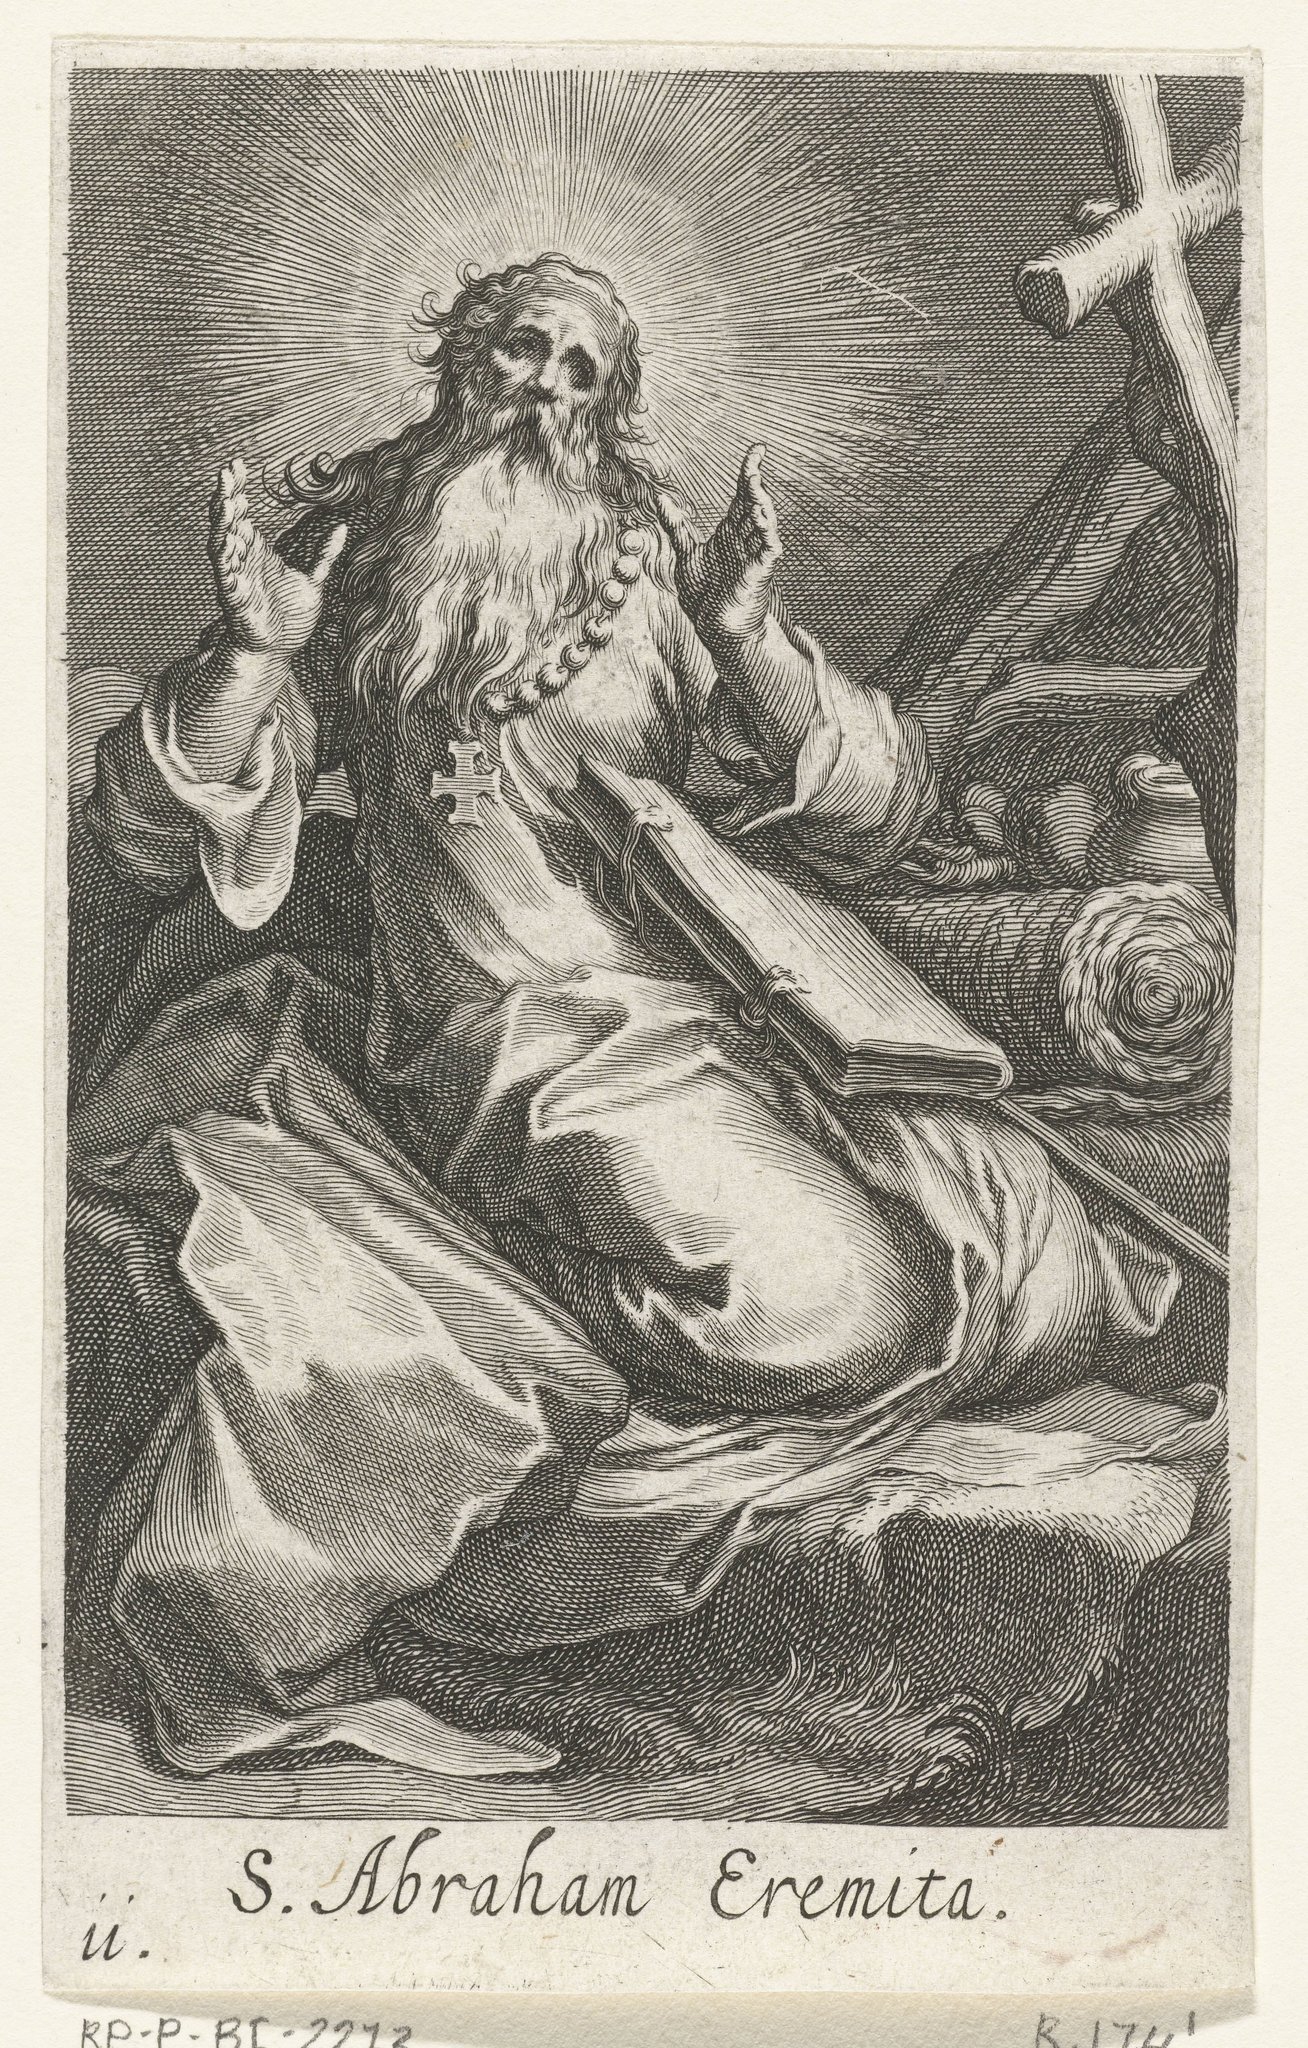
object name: book illustration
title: Sacra eremvs ascetarvm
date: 1590-1612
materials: paper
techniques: engraving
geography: antwerp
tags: saints, anchorite, hermit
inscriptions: collector's mark: Lugt 240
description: Prent uit: Sacra eremus ascetarum, Antwerpen, Hendrick Aertssen, 1619. Eerste gebonden uitgave met in totaal vijftig prenten. Prent uit serie van vijfentwintig mannelijke kluizenaars. In 1612 verscheen een ongebonden editie maar op basis van de gewijzigde opschriften en samenstelling wordt aangenomen dat de prenten van de uitgave 1619 ook in 1612 of iets daarvoor gedrukt werden. Roethlisberger beschouwt de uitgave van 1619 als de eerste staat en de ongebonden editie van 1612 als de tweede staat (Roethlisberger 1993, p. 171, 172).